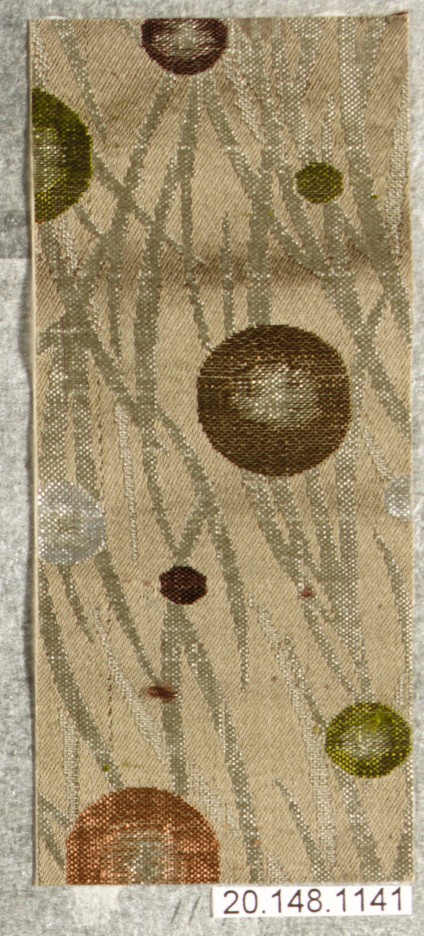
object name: piece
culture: japanese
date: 1801-1900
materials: silk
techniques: compound weave